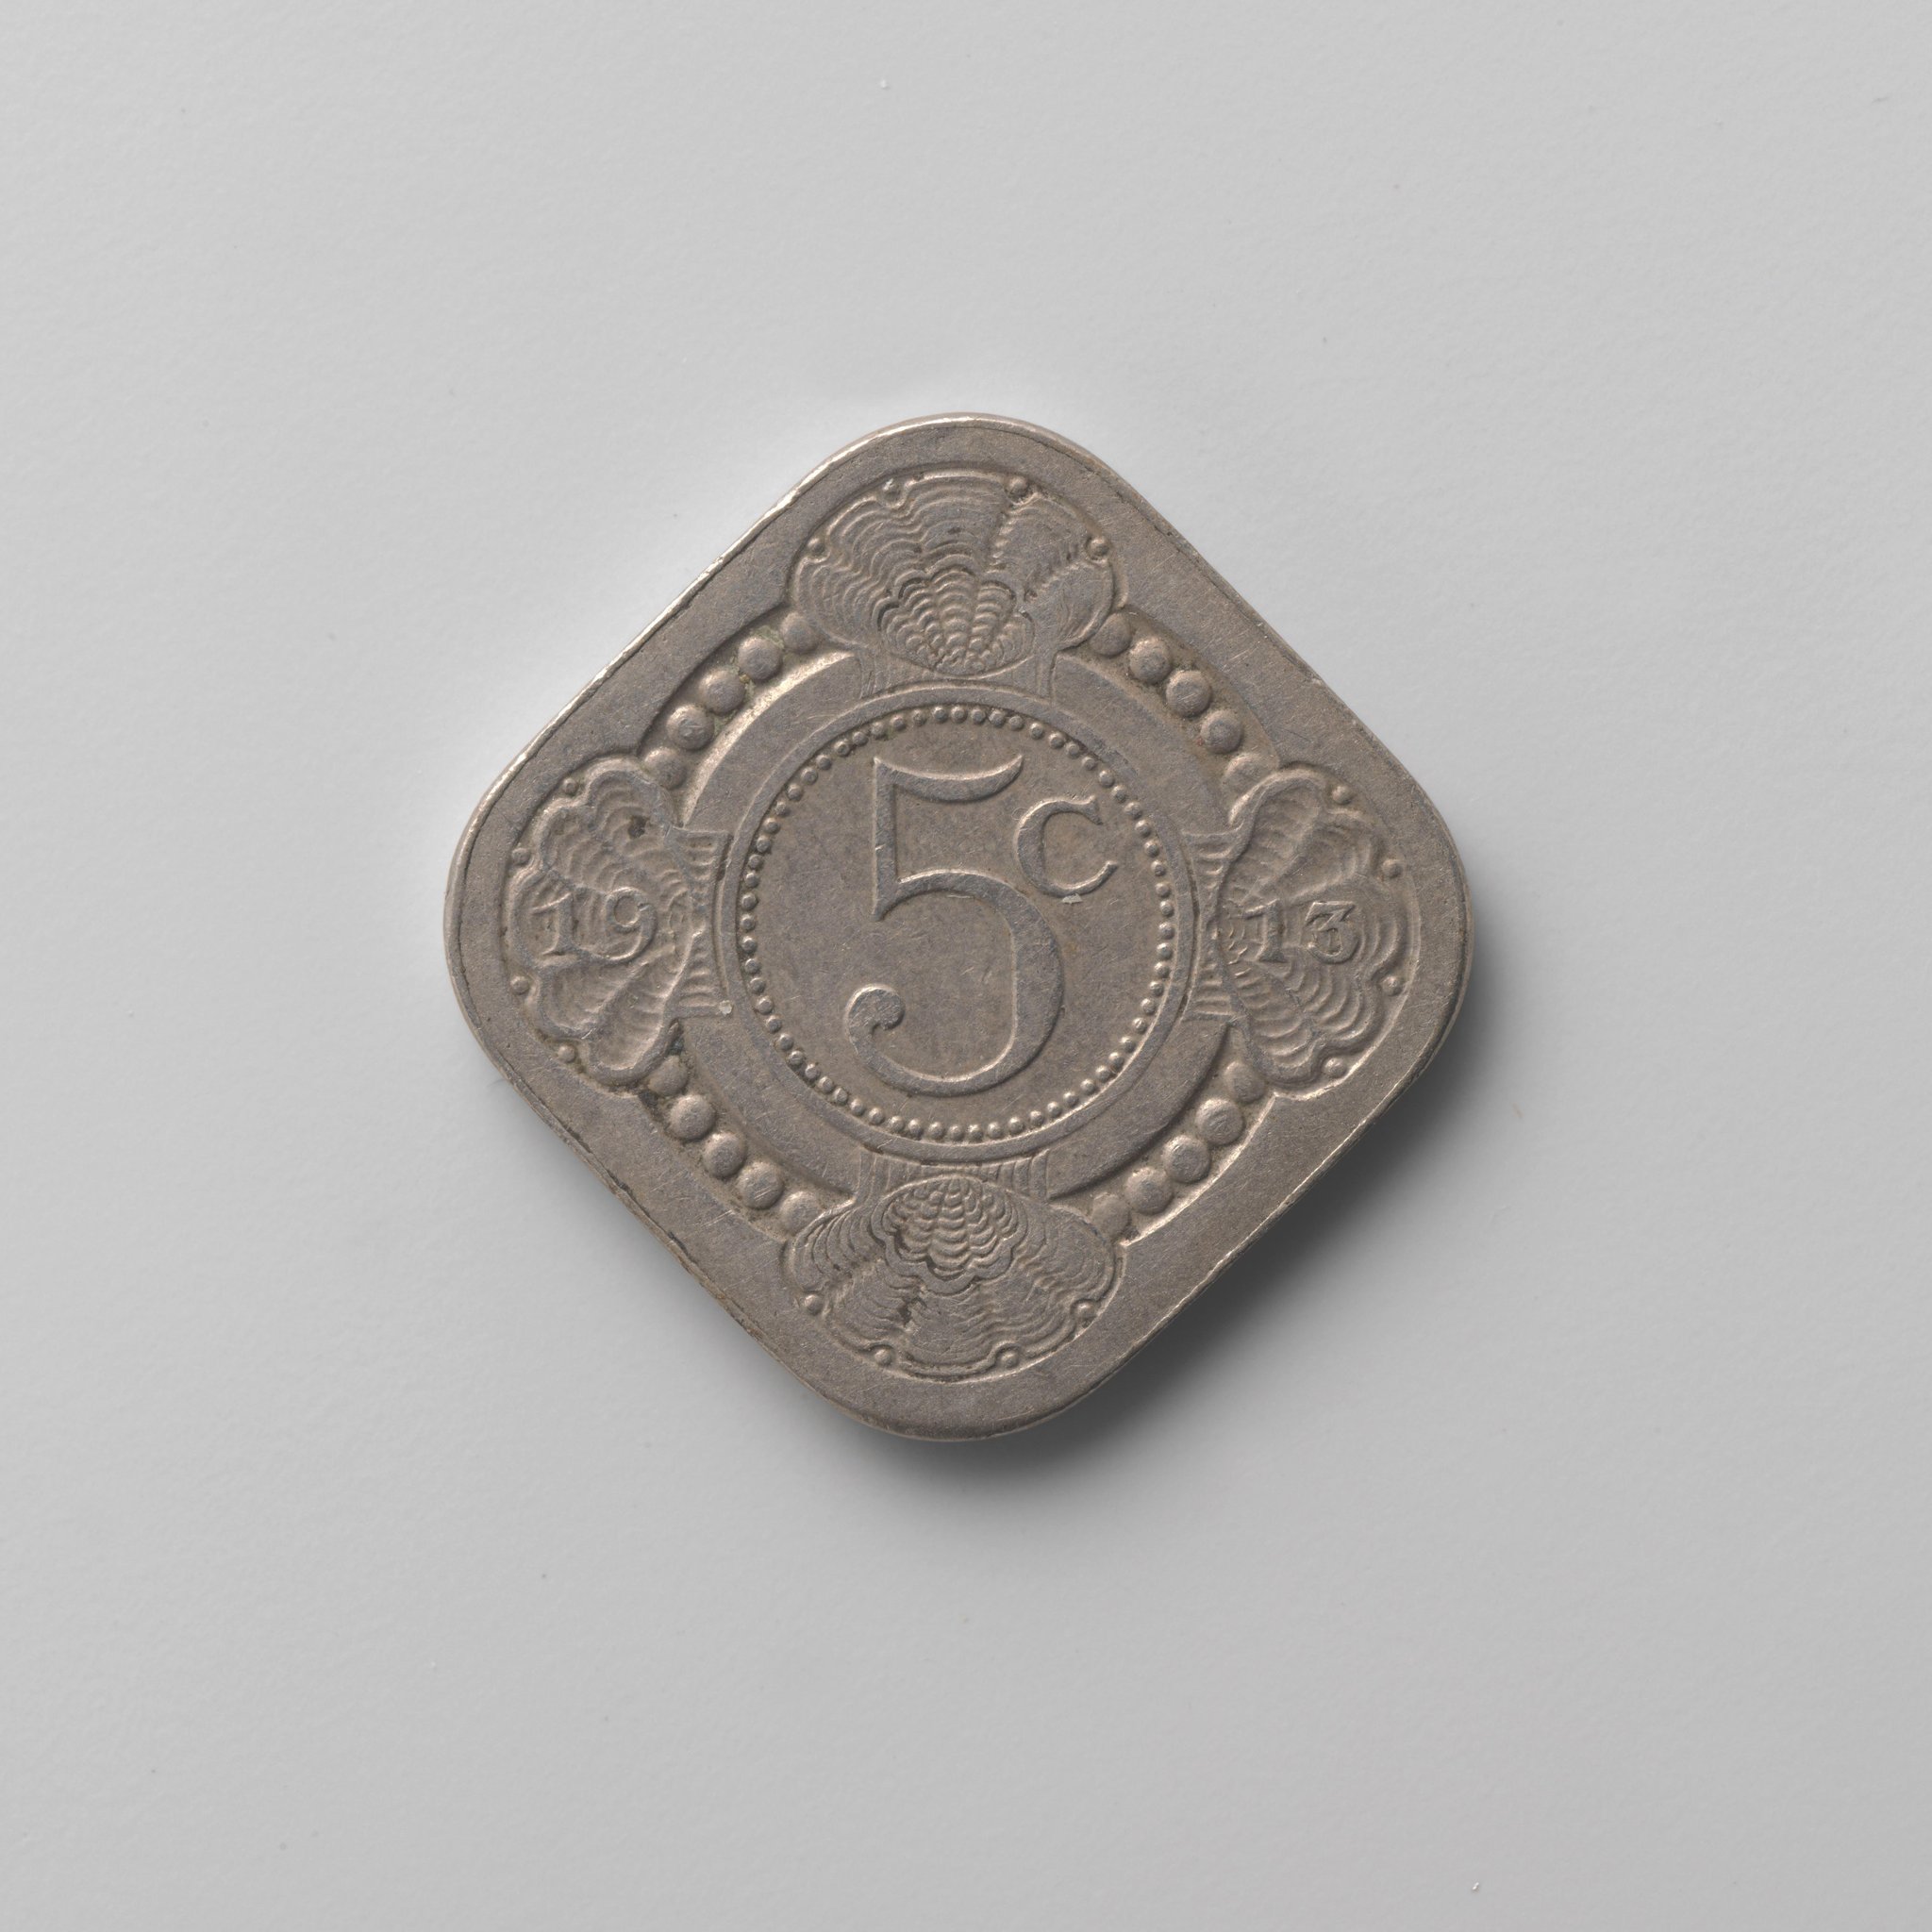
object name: vijf cent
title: Nederland, 5 cent,1913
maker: wilhelmina of the netherlands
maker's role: print maker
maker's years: 1880-1962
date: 1913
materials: nickel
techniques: striking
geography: utrecht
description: Vierkante nikkelen munt. Voorzijde: in hoeken versiering, daarbinnen twee cirkels, waarin landsaanduiding. Daarbinnen vruchtdragende tak van een oranje-appel. Keerzijde: in de vier hoeken schelpen-versiering, verbonden door parels. Daarbinnen waarde-aanduiding 5 C in parelrand. Jaartal in de twee schelpen links en rechts. Gladde rand.